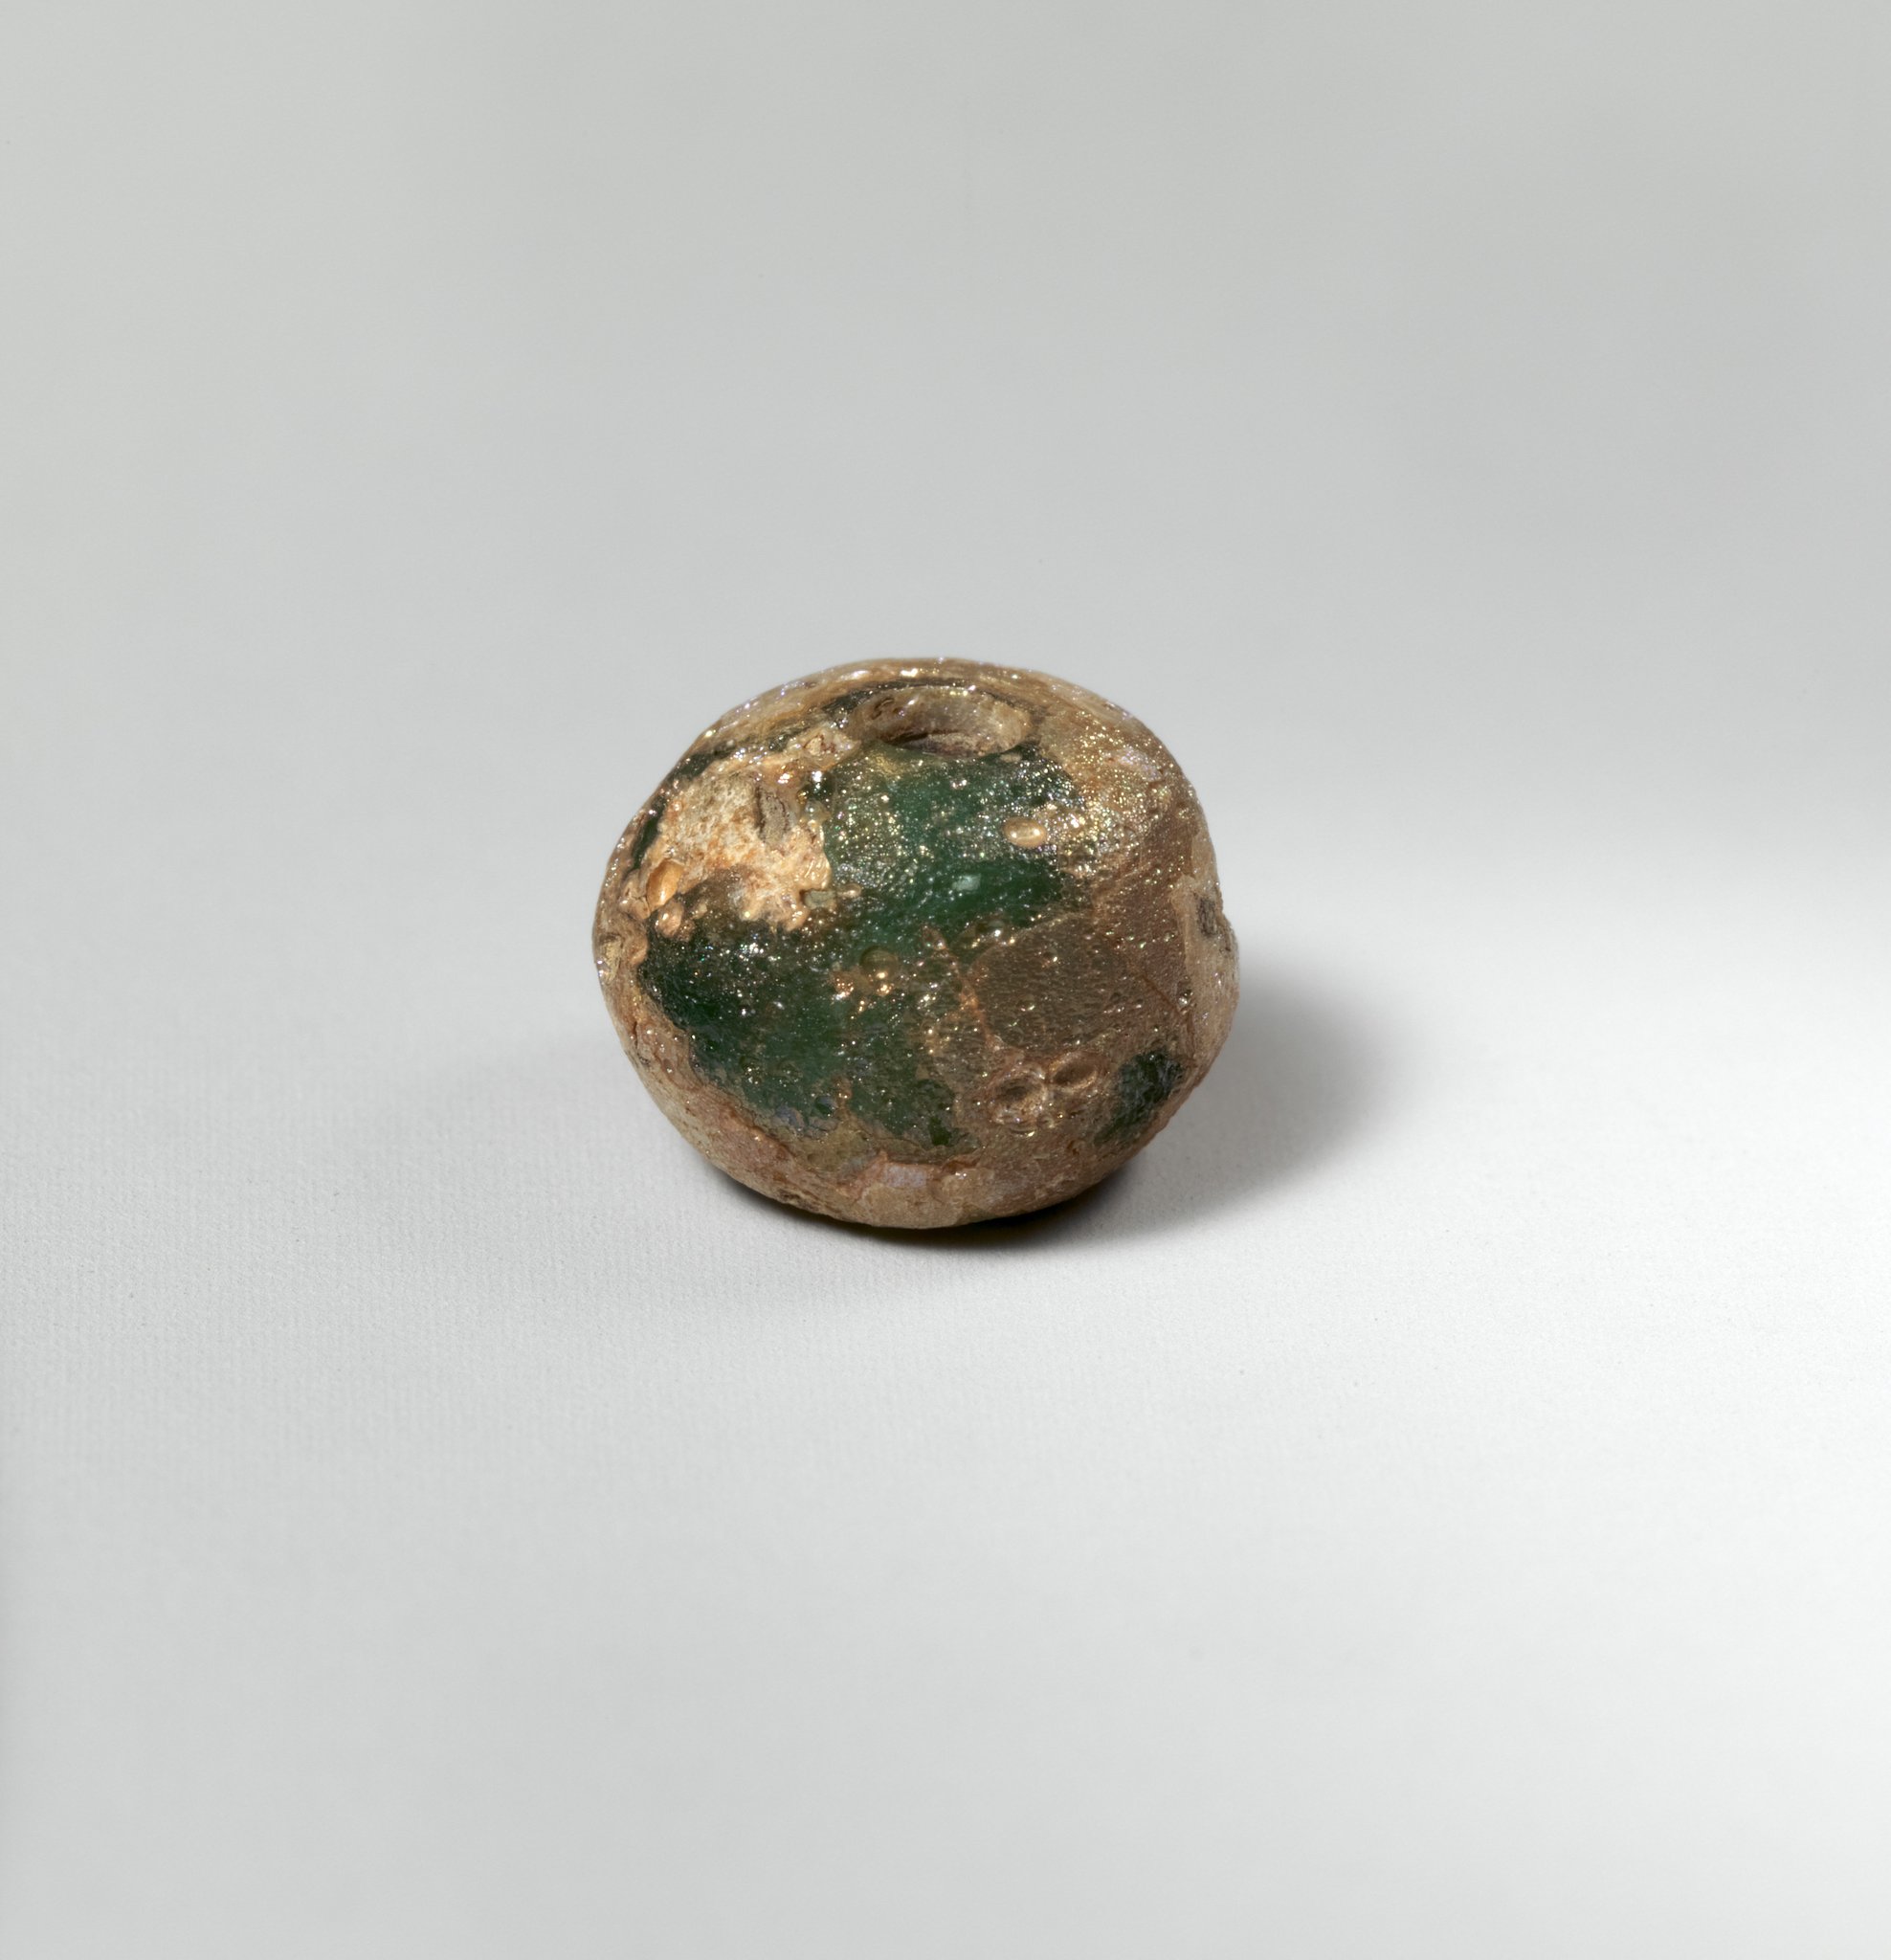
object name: bead, spherical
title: Glass bead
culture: roman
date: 1-400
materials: glass